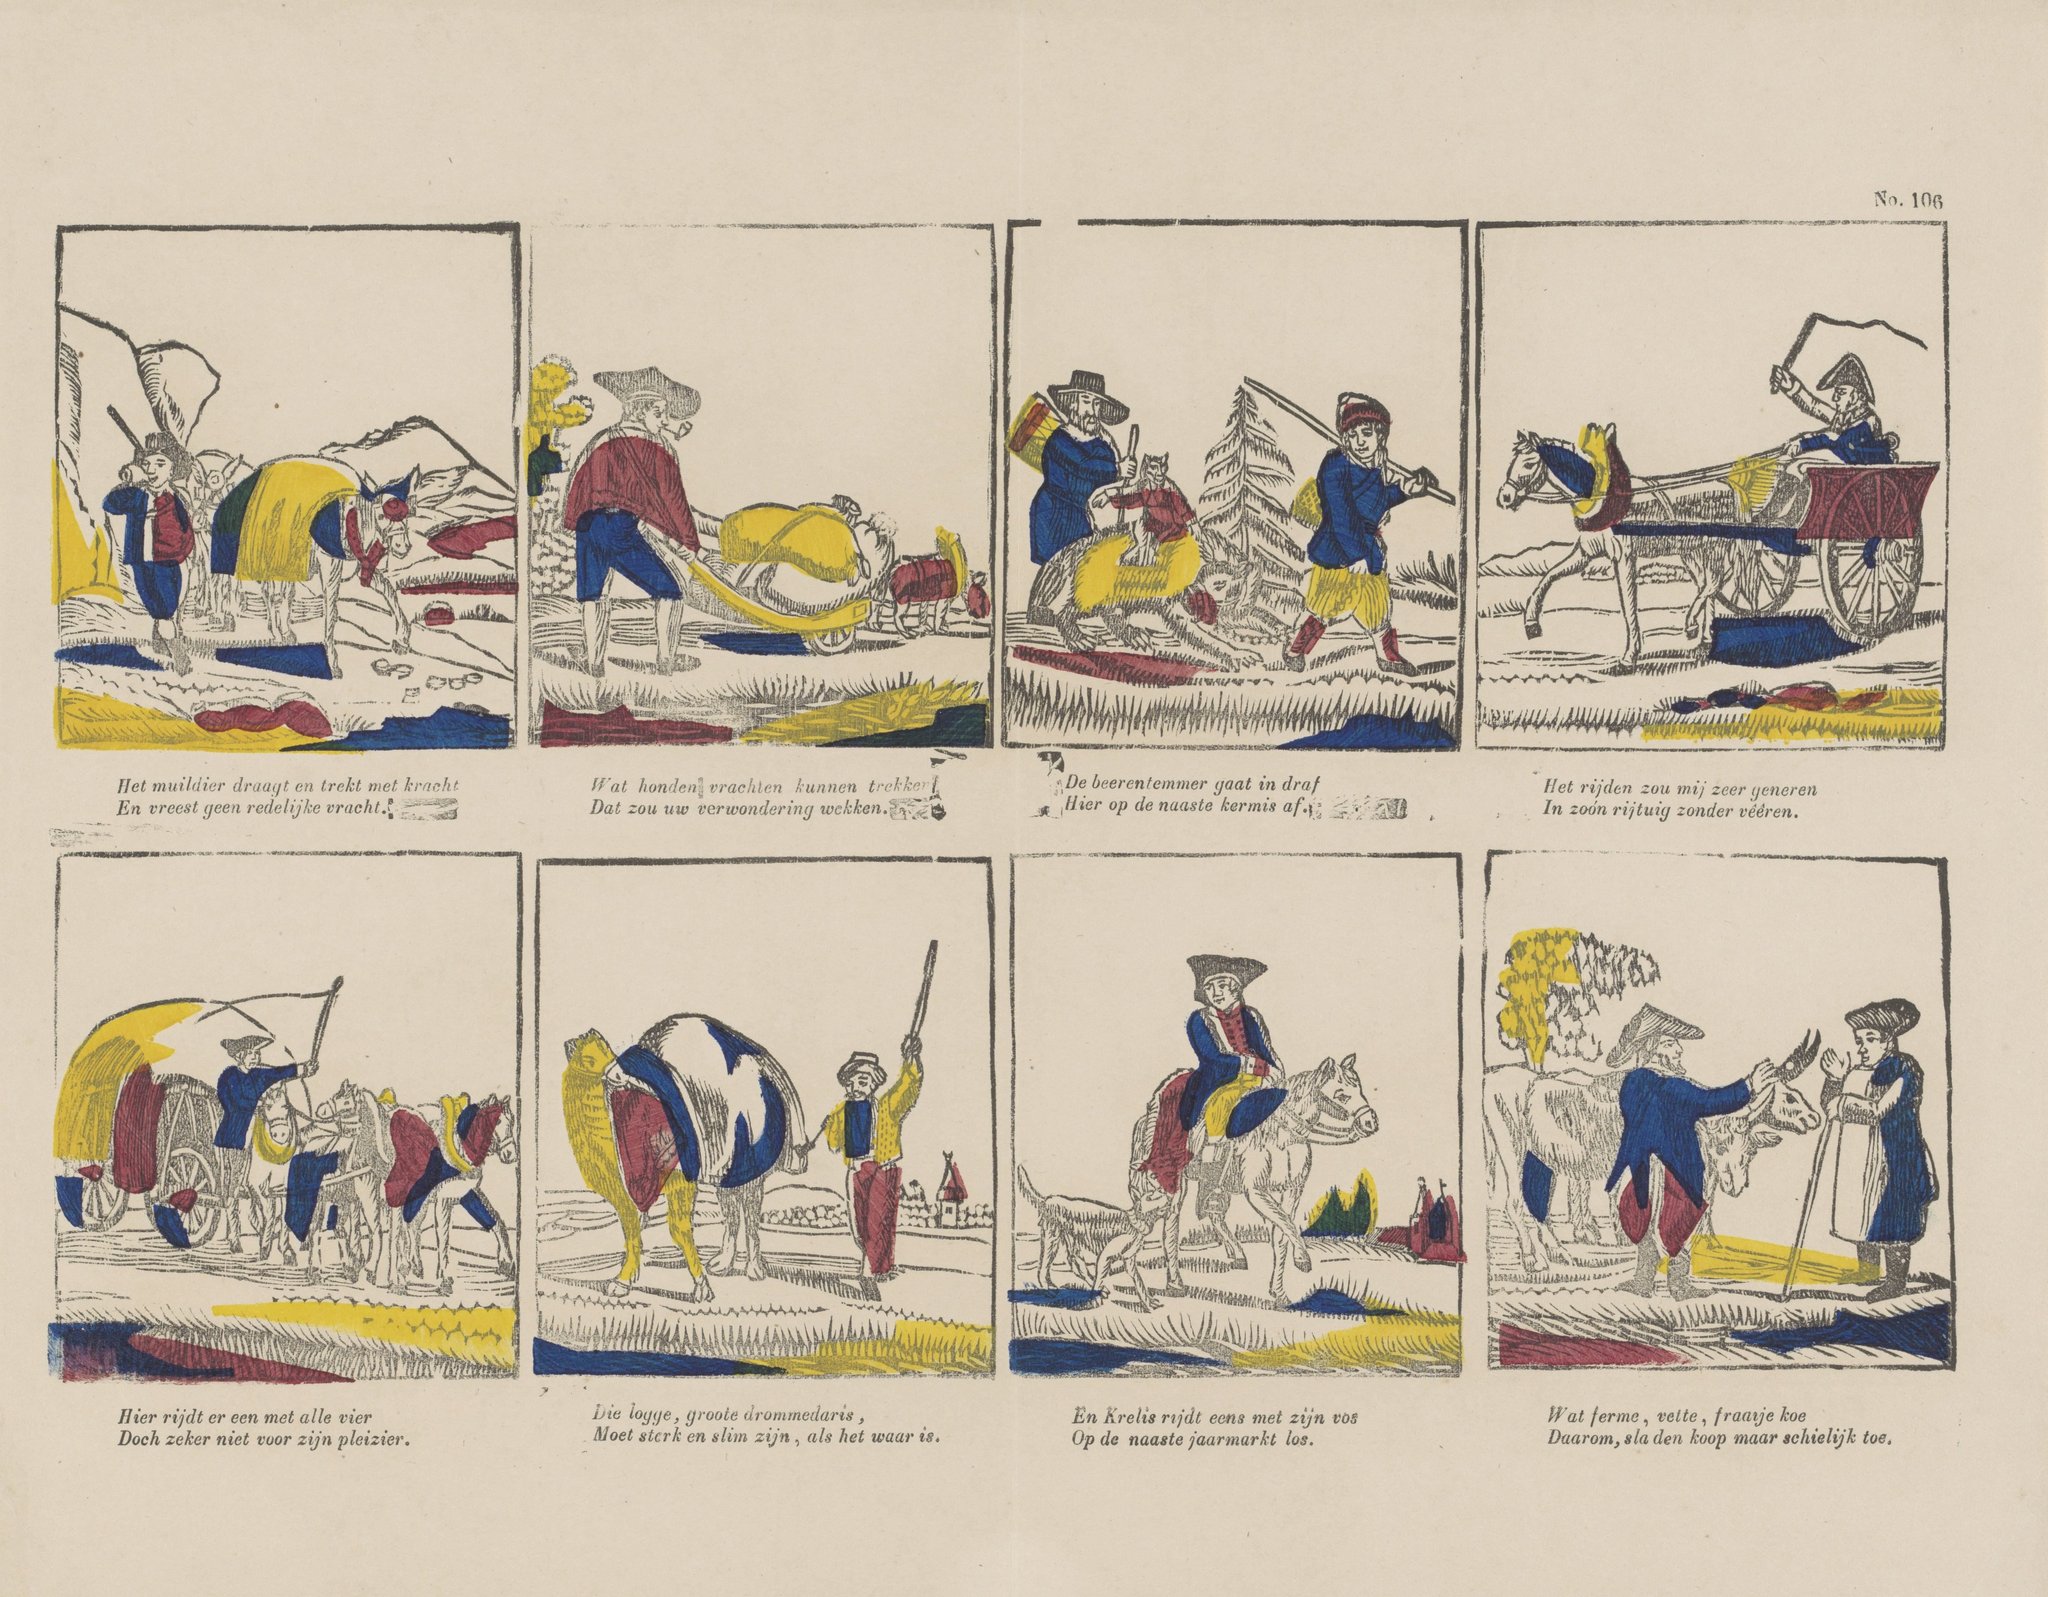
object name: popular print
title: Mensen en dieren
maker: Anonymous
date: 1848-1881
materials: paper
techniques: colour, letterpress printing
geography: netherlands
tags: riding a horse, ass, or mule; rider, horseman, animals, human types, farmers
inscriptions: collector's mark: Lugt 2760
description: Blad met 8 voorstellingen van mensen en dieren. Onder elke voorstelling een tweeregelig vers. Genummerd rechtsboven: No. 106.